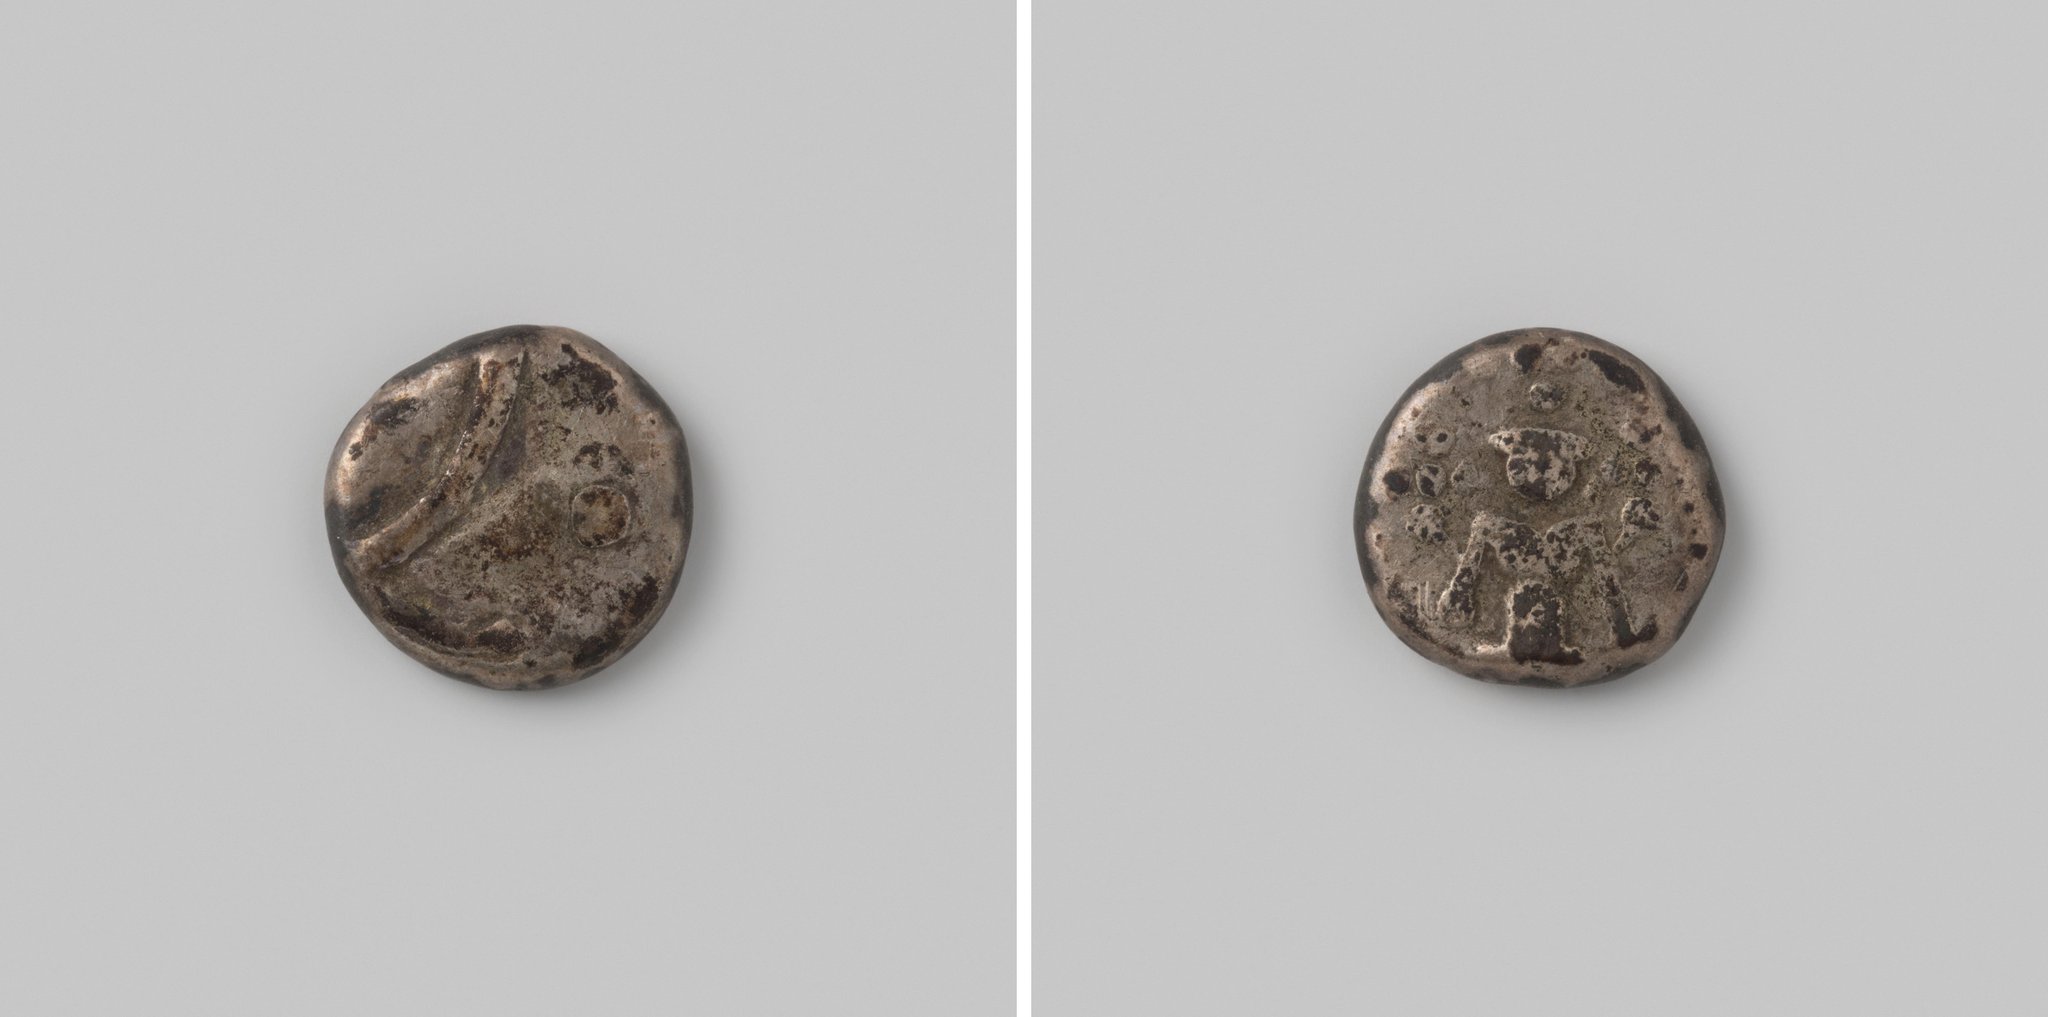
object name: coin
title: Zilveren fanam uit Madras in Brits Indië onder de East India Company,1764-1807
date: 1764-1807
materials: silver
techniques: striking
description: Zilveren munt. Voorzijde: afbeelding van de Godheid Vishnu. Keerzijde: twee naar elkaar gewende en in elkaar verstrengelde letters C [=Company].